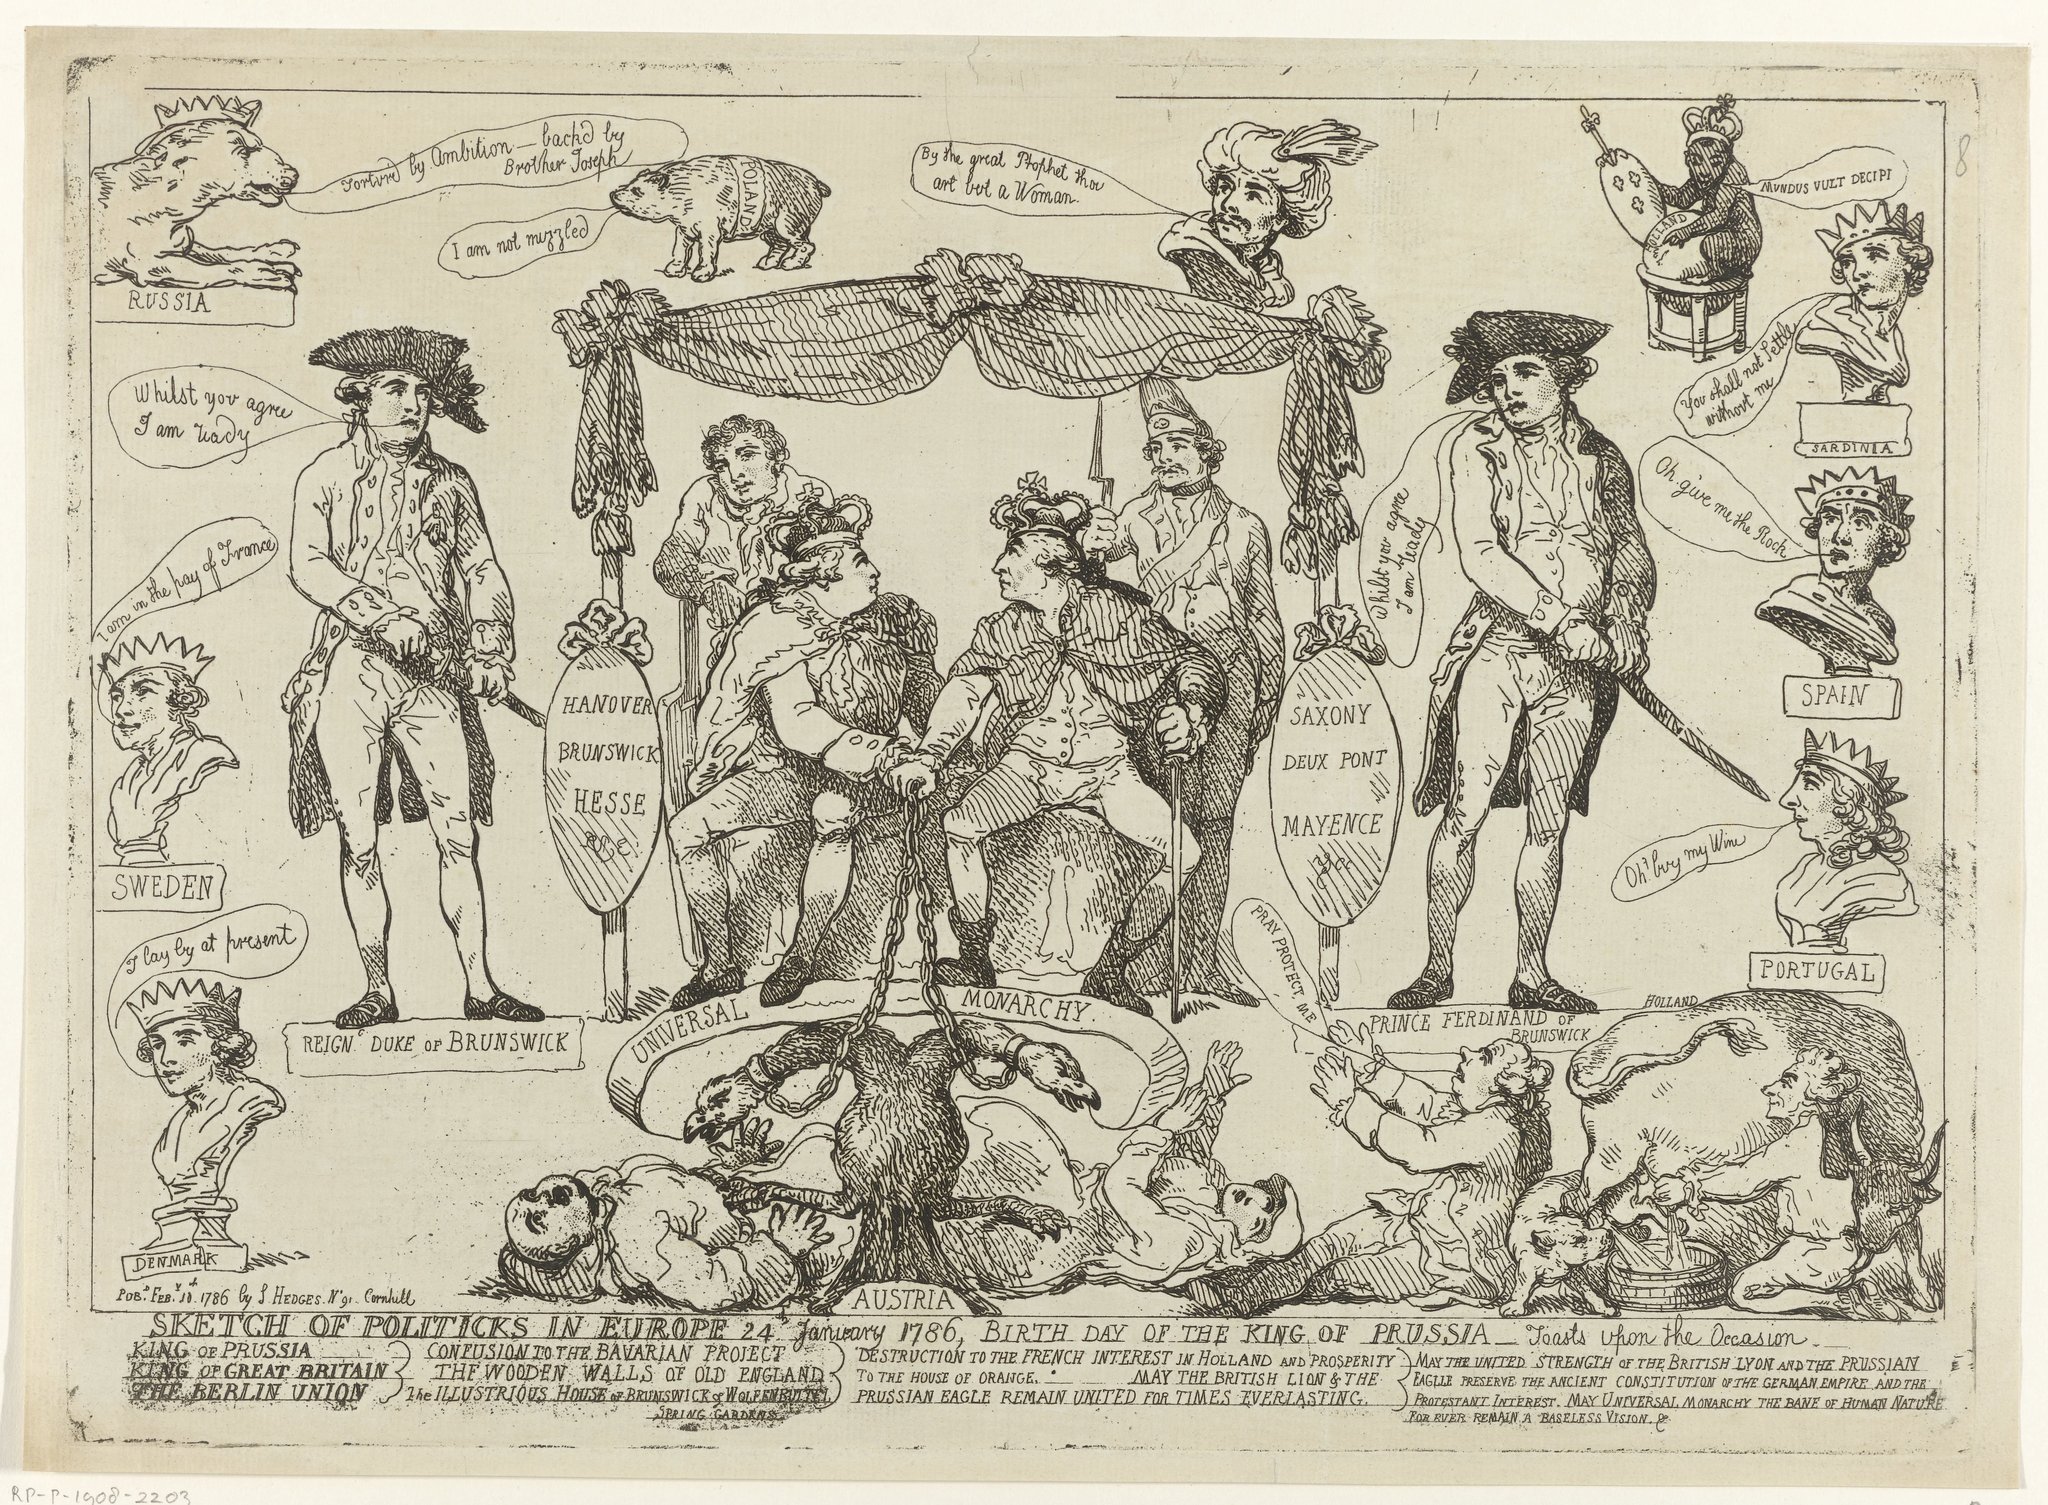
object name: cartoon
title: Spotprent op de toestand in Europa, 1786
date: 1786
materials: paper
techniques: etching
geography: london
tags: william v (prince of orange), frederick ii (king of prussia), george iii (koning van het verenigd koninkrijk), political caricatures and satires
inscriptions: collector's mark: Lugt 2228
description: Spotprent op de toestand in Europa op 24 januari 1786 (de verjaardag van de koning van Pruisen). Centraal zittend naast elkaar de Engelse koning George III en Frederik II van Pruisen op hun tronen onder een baldakijn. Dit symboliseert het verbond tussen deze twee landen om een front te vormen tegen de Oostenrijkse keizer en Frankrijk. Dit alles ten koste van Nederland. Onderaan twee Nederlanders in de klauwen van de Habsburgse adelaar. Rechts wordt de Hollandse koe gemolken door Frankrijk. Stadhouder Willem V smeekt de twee koningen om hulp. Verder verwijzingen naar andere Europese landen en vorsten.